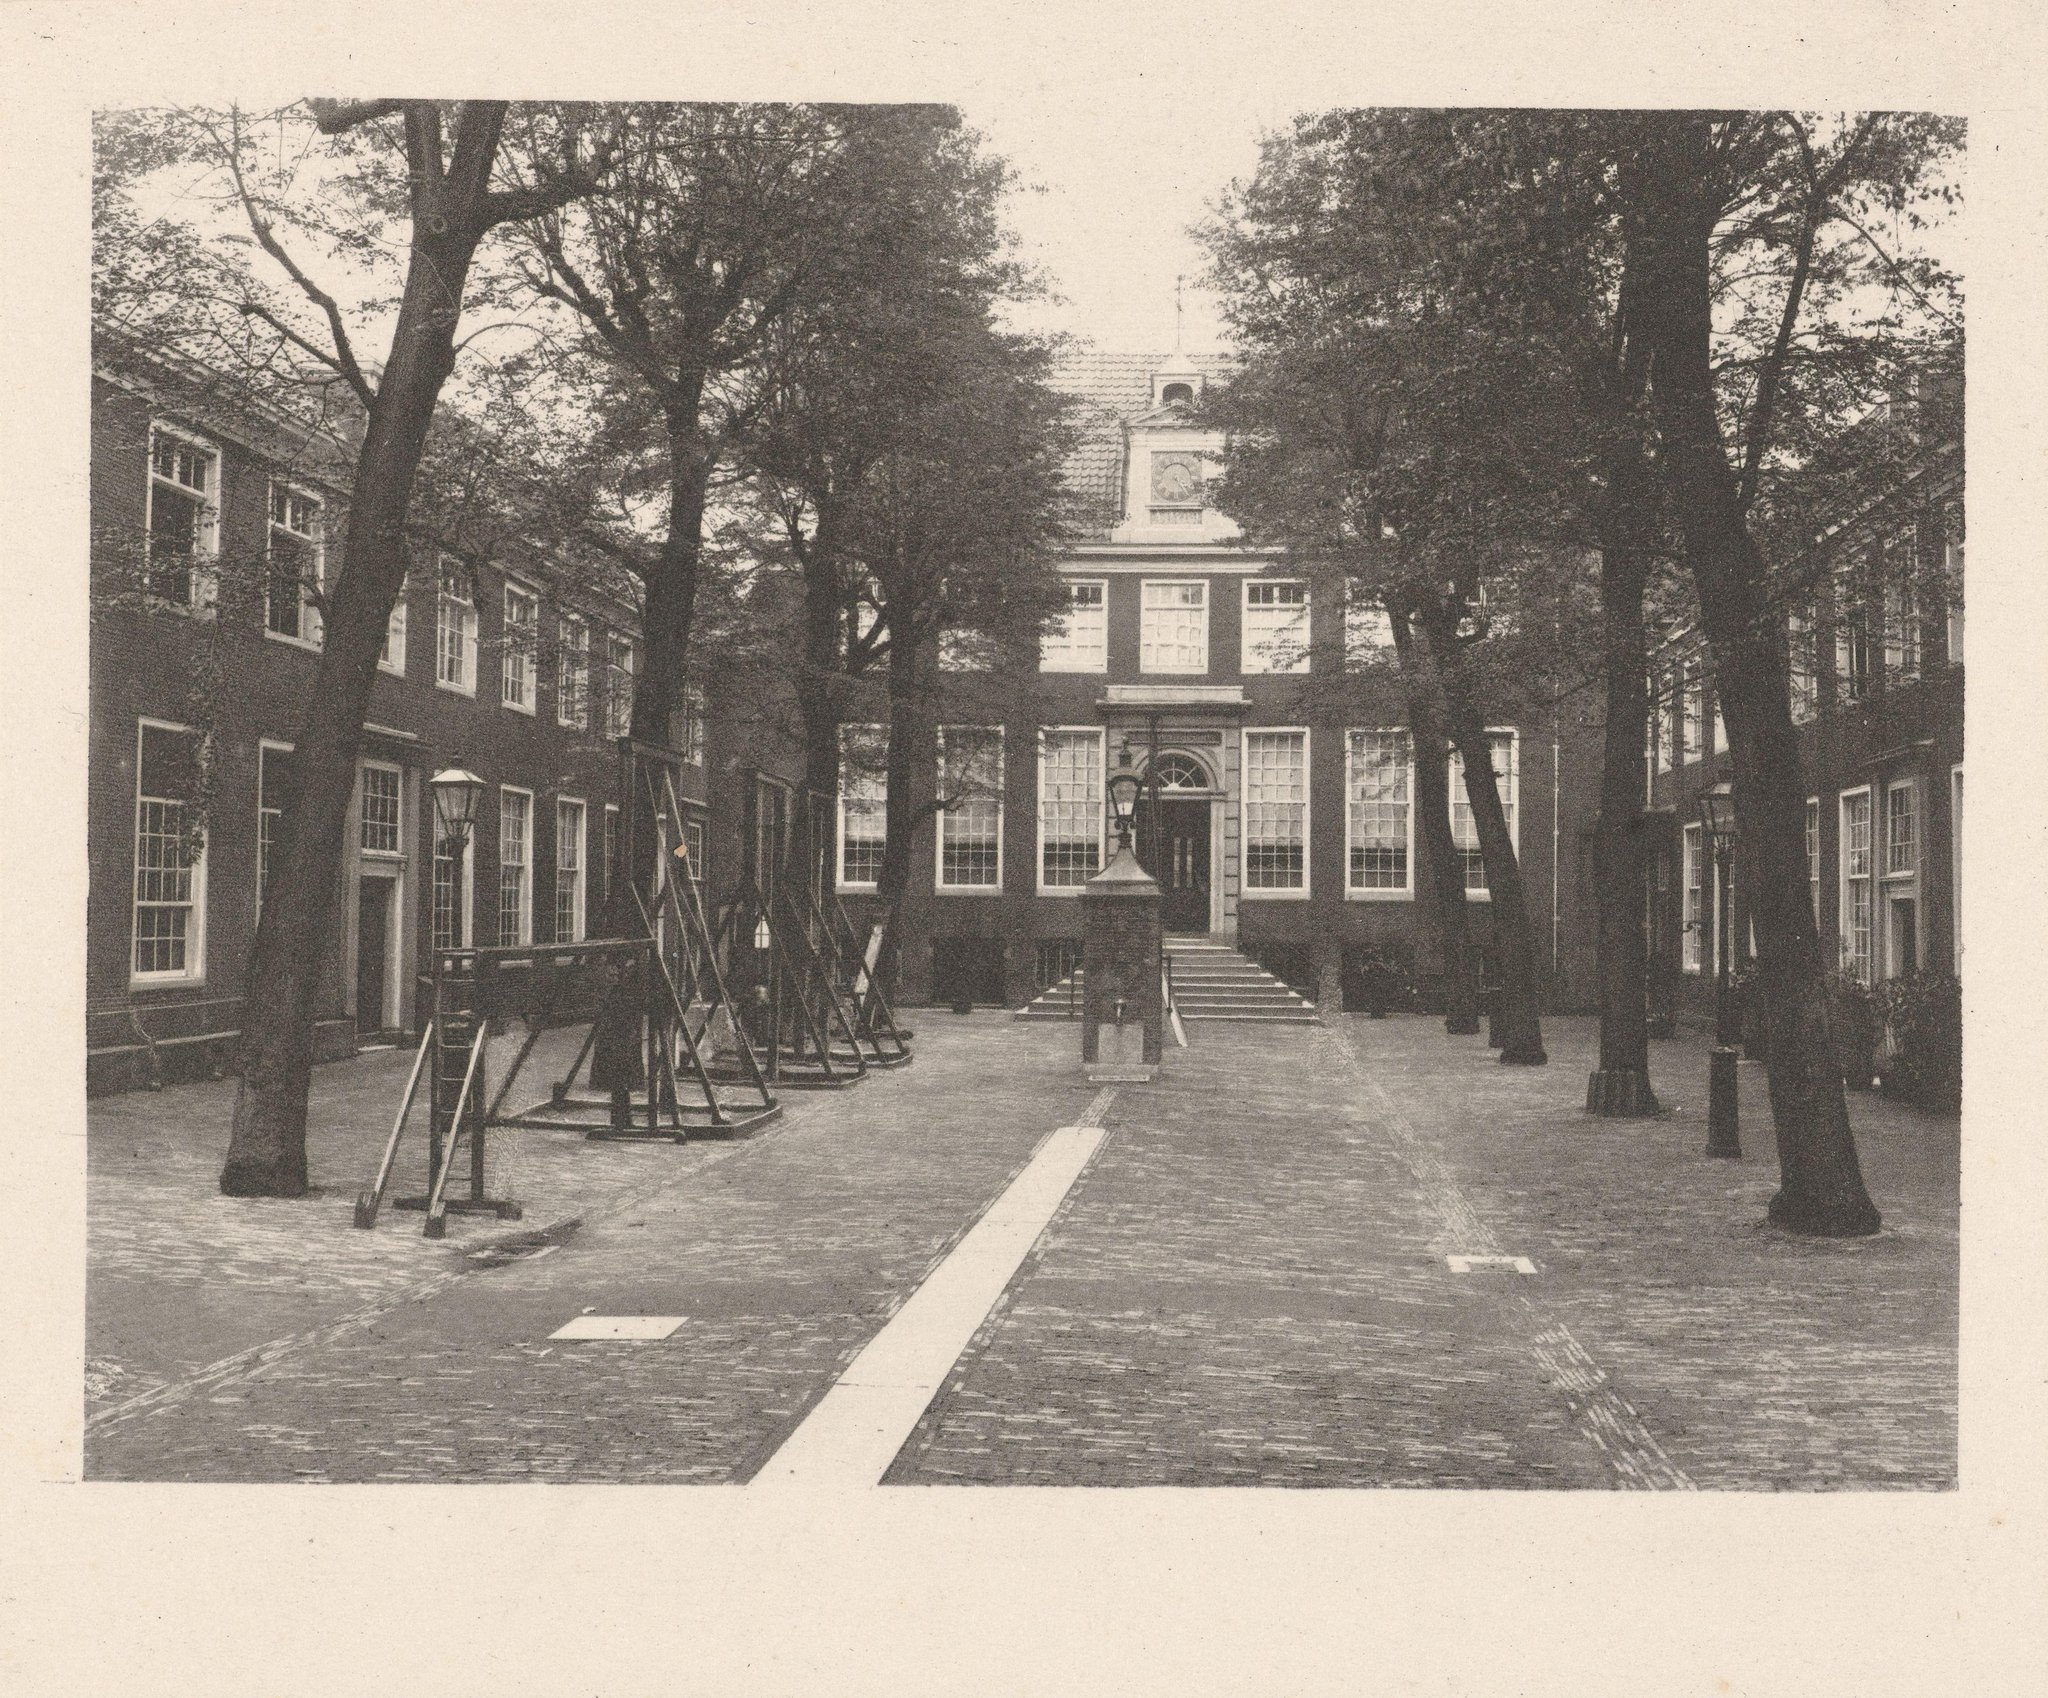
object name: photograph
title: Gezicht op het Plataanhof in Amsterdam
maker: Anonymous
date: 1900-1970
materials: paper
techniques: bromoil process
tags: amsterdam